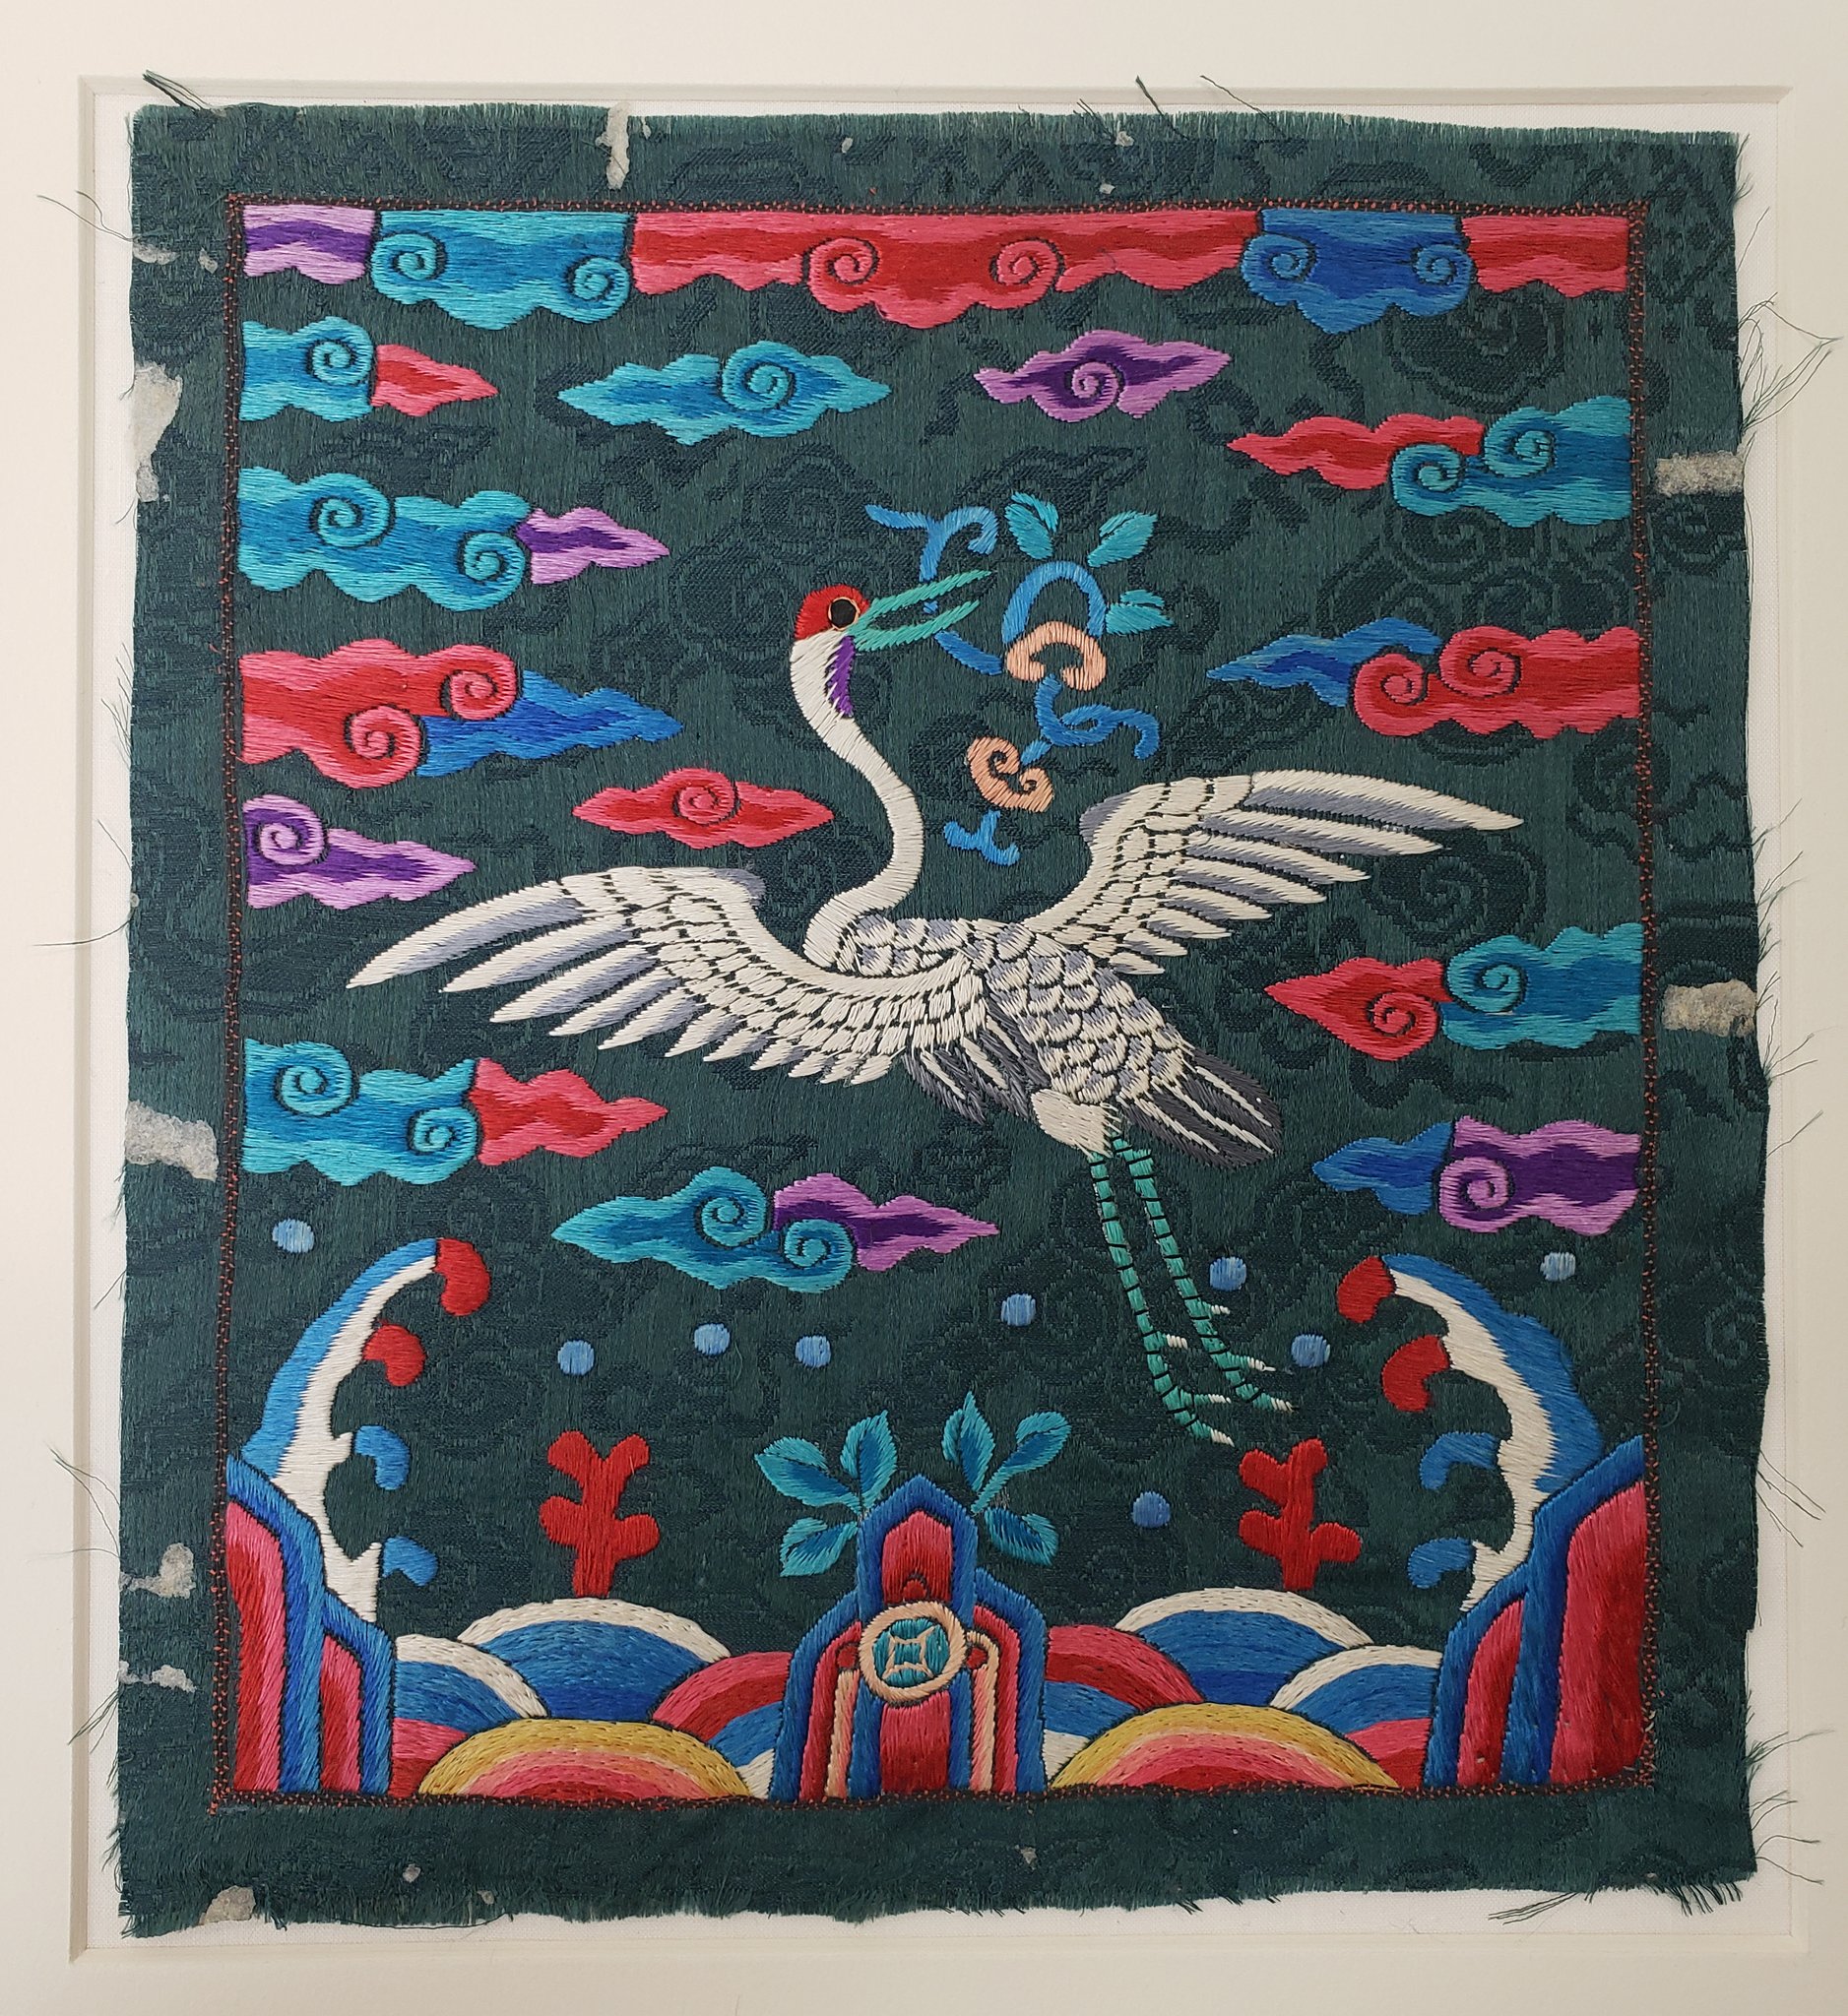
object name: rank badge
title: Rank Badge with Crane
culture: korean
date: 1867-1900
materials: silk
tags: cranes